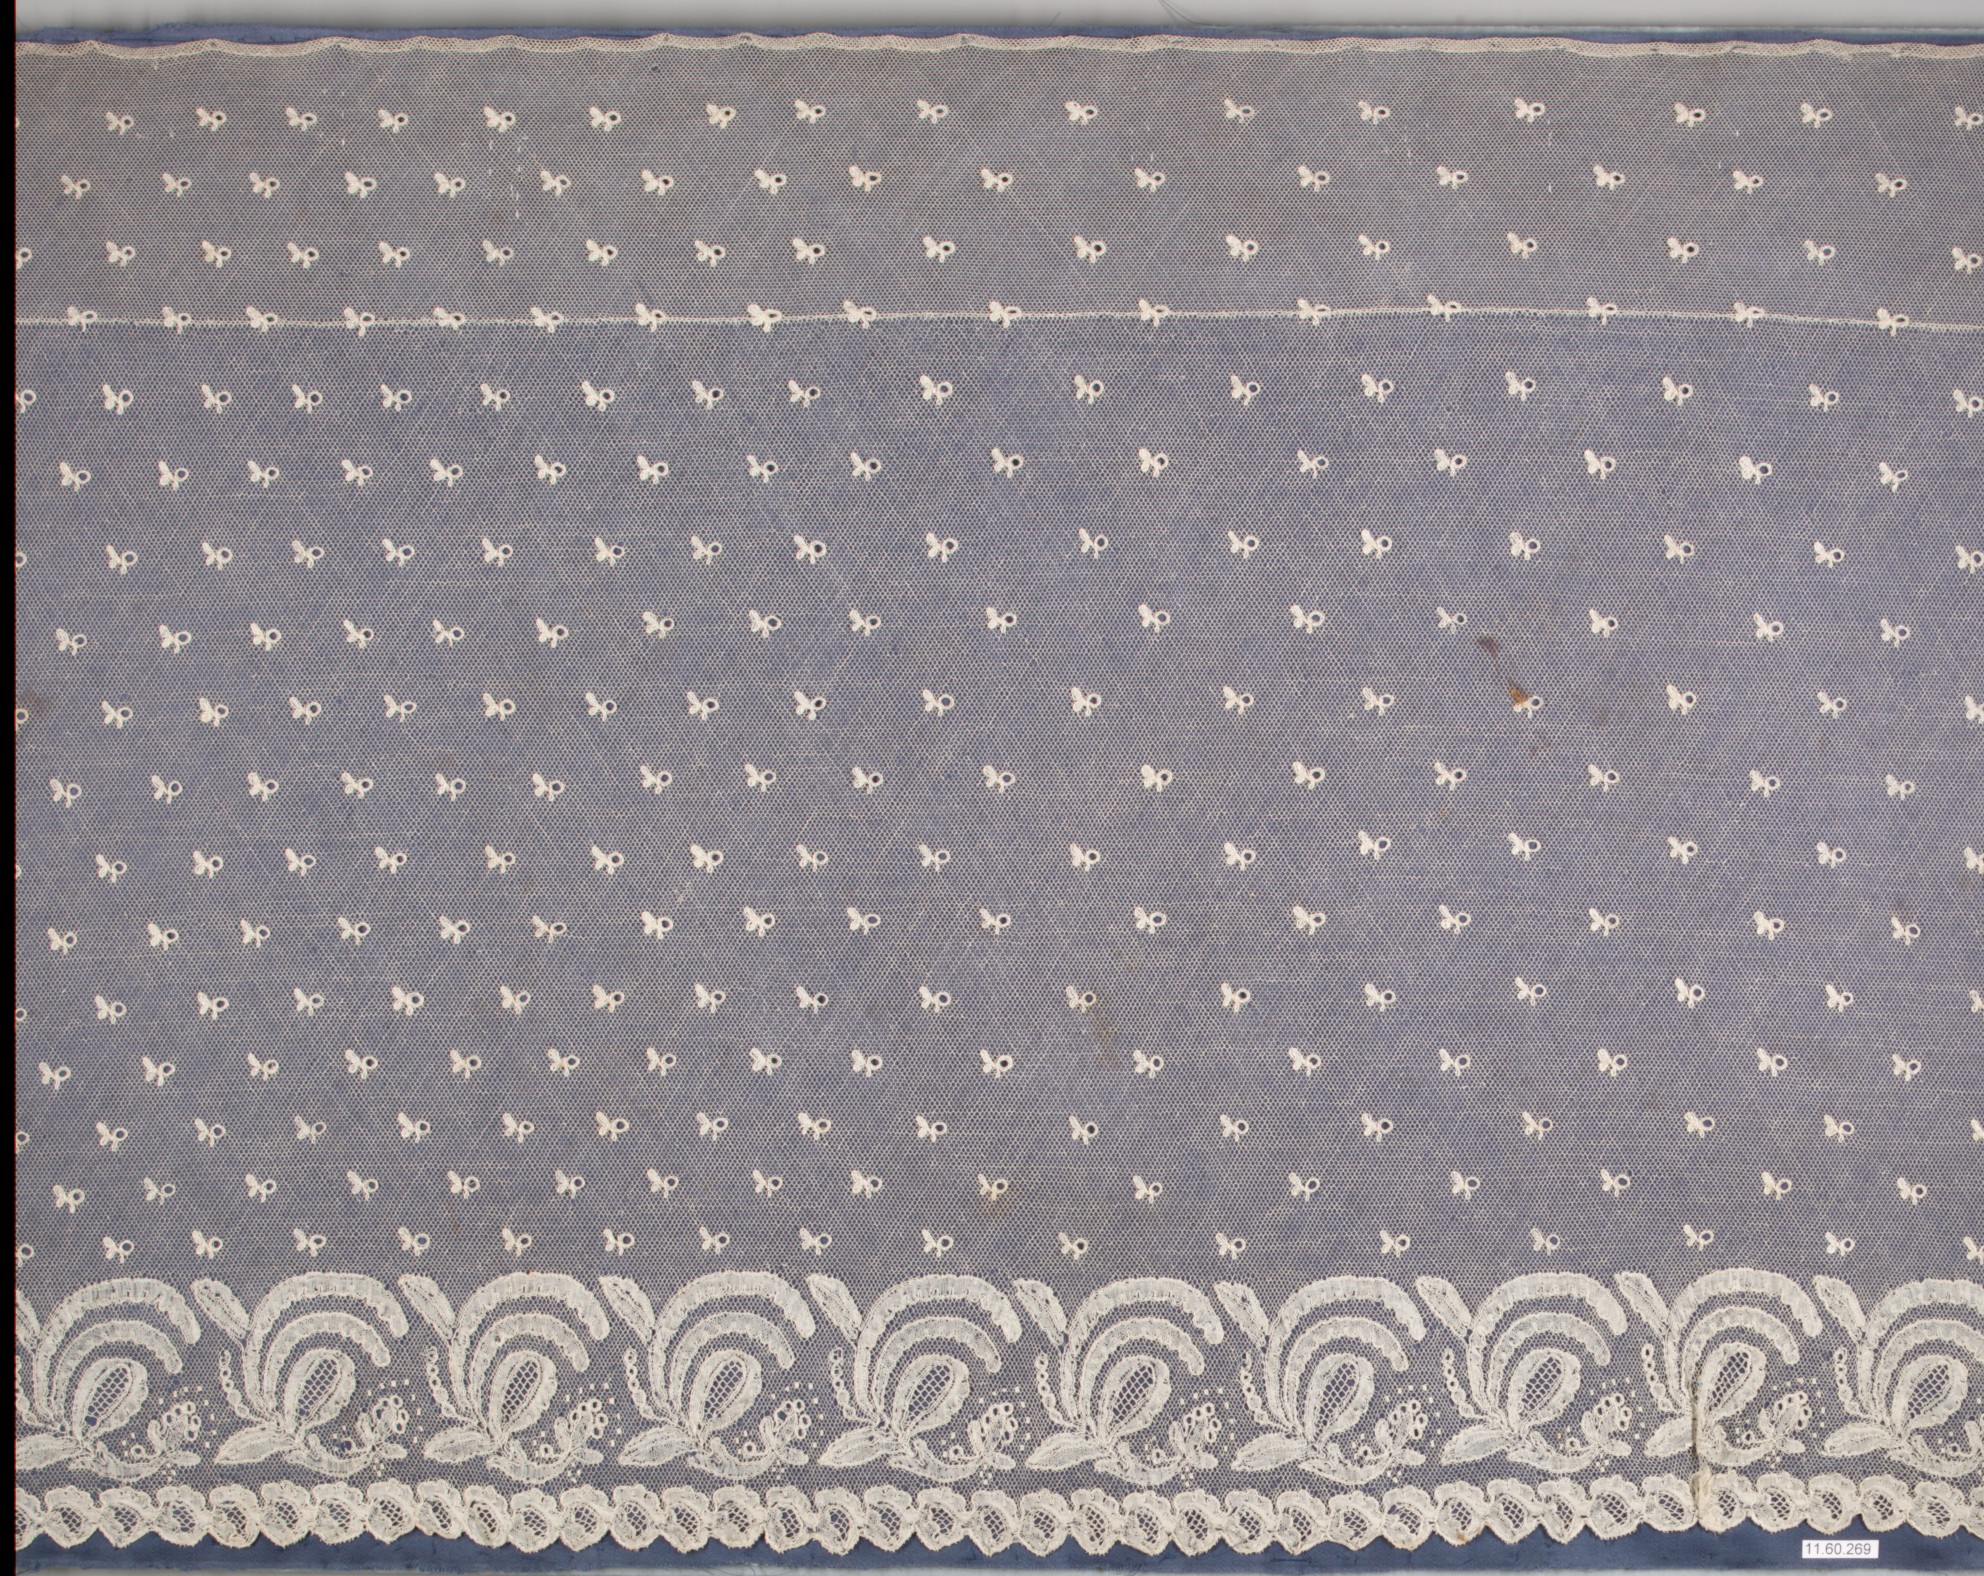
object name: veil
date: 1801-1900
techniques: lace